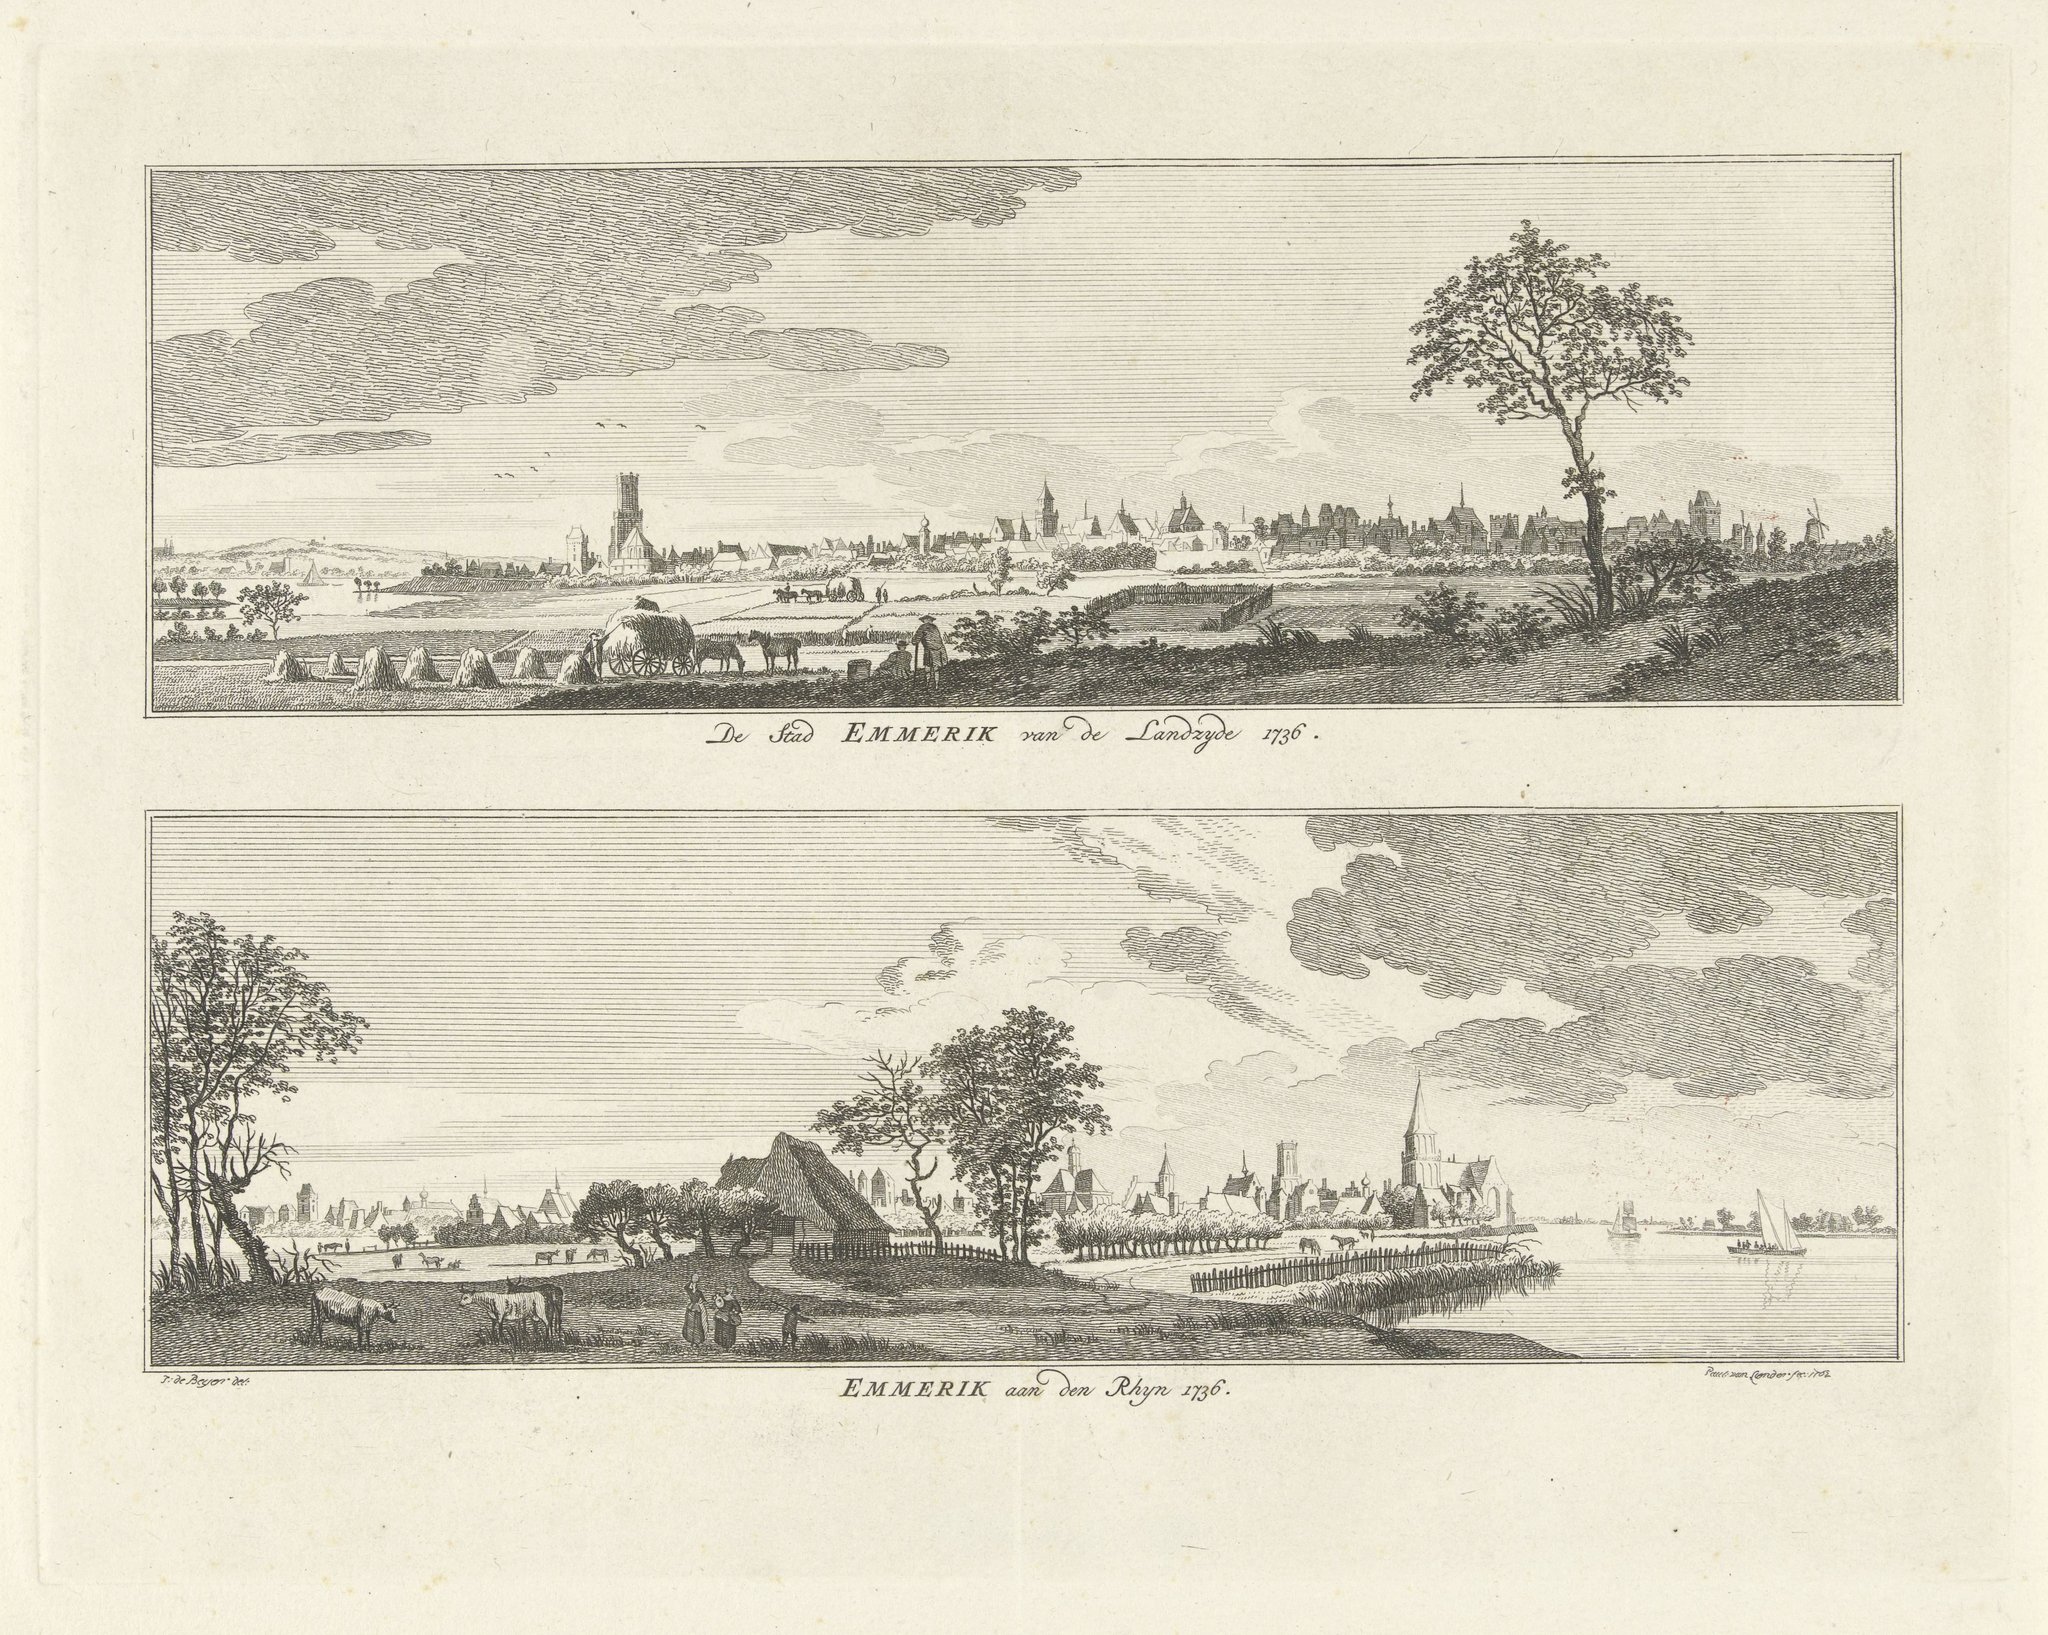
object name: print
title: Gezichten op Emmerik aan de Rijn, 1736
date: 1762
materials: paper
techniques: etching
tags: landscapes with waters, waterscapes, seascapes (in the temperate zone), prospect of city, town panorama, silhouette of city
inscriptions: collector's mark: Lugt 240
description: Twee gezichten op de Duitse stad Emmerik, gelegen aan de Rijn. Op de voorgrond landerijen met vee en boeren. Twee voorstellingen van één plaat.